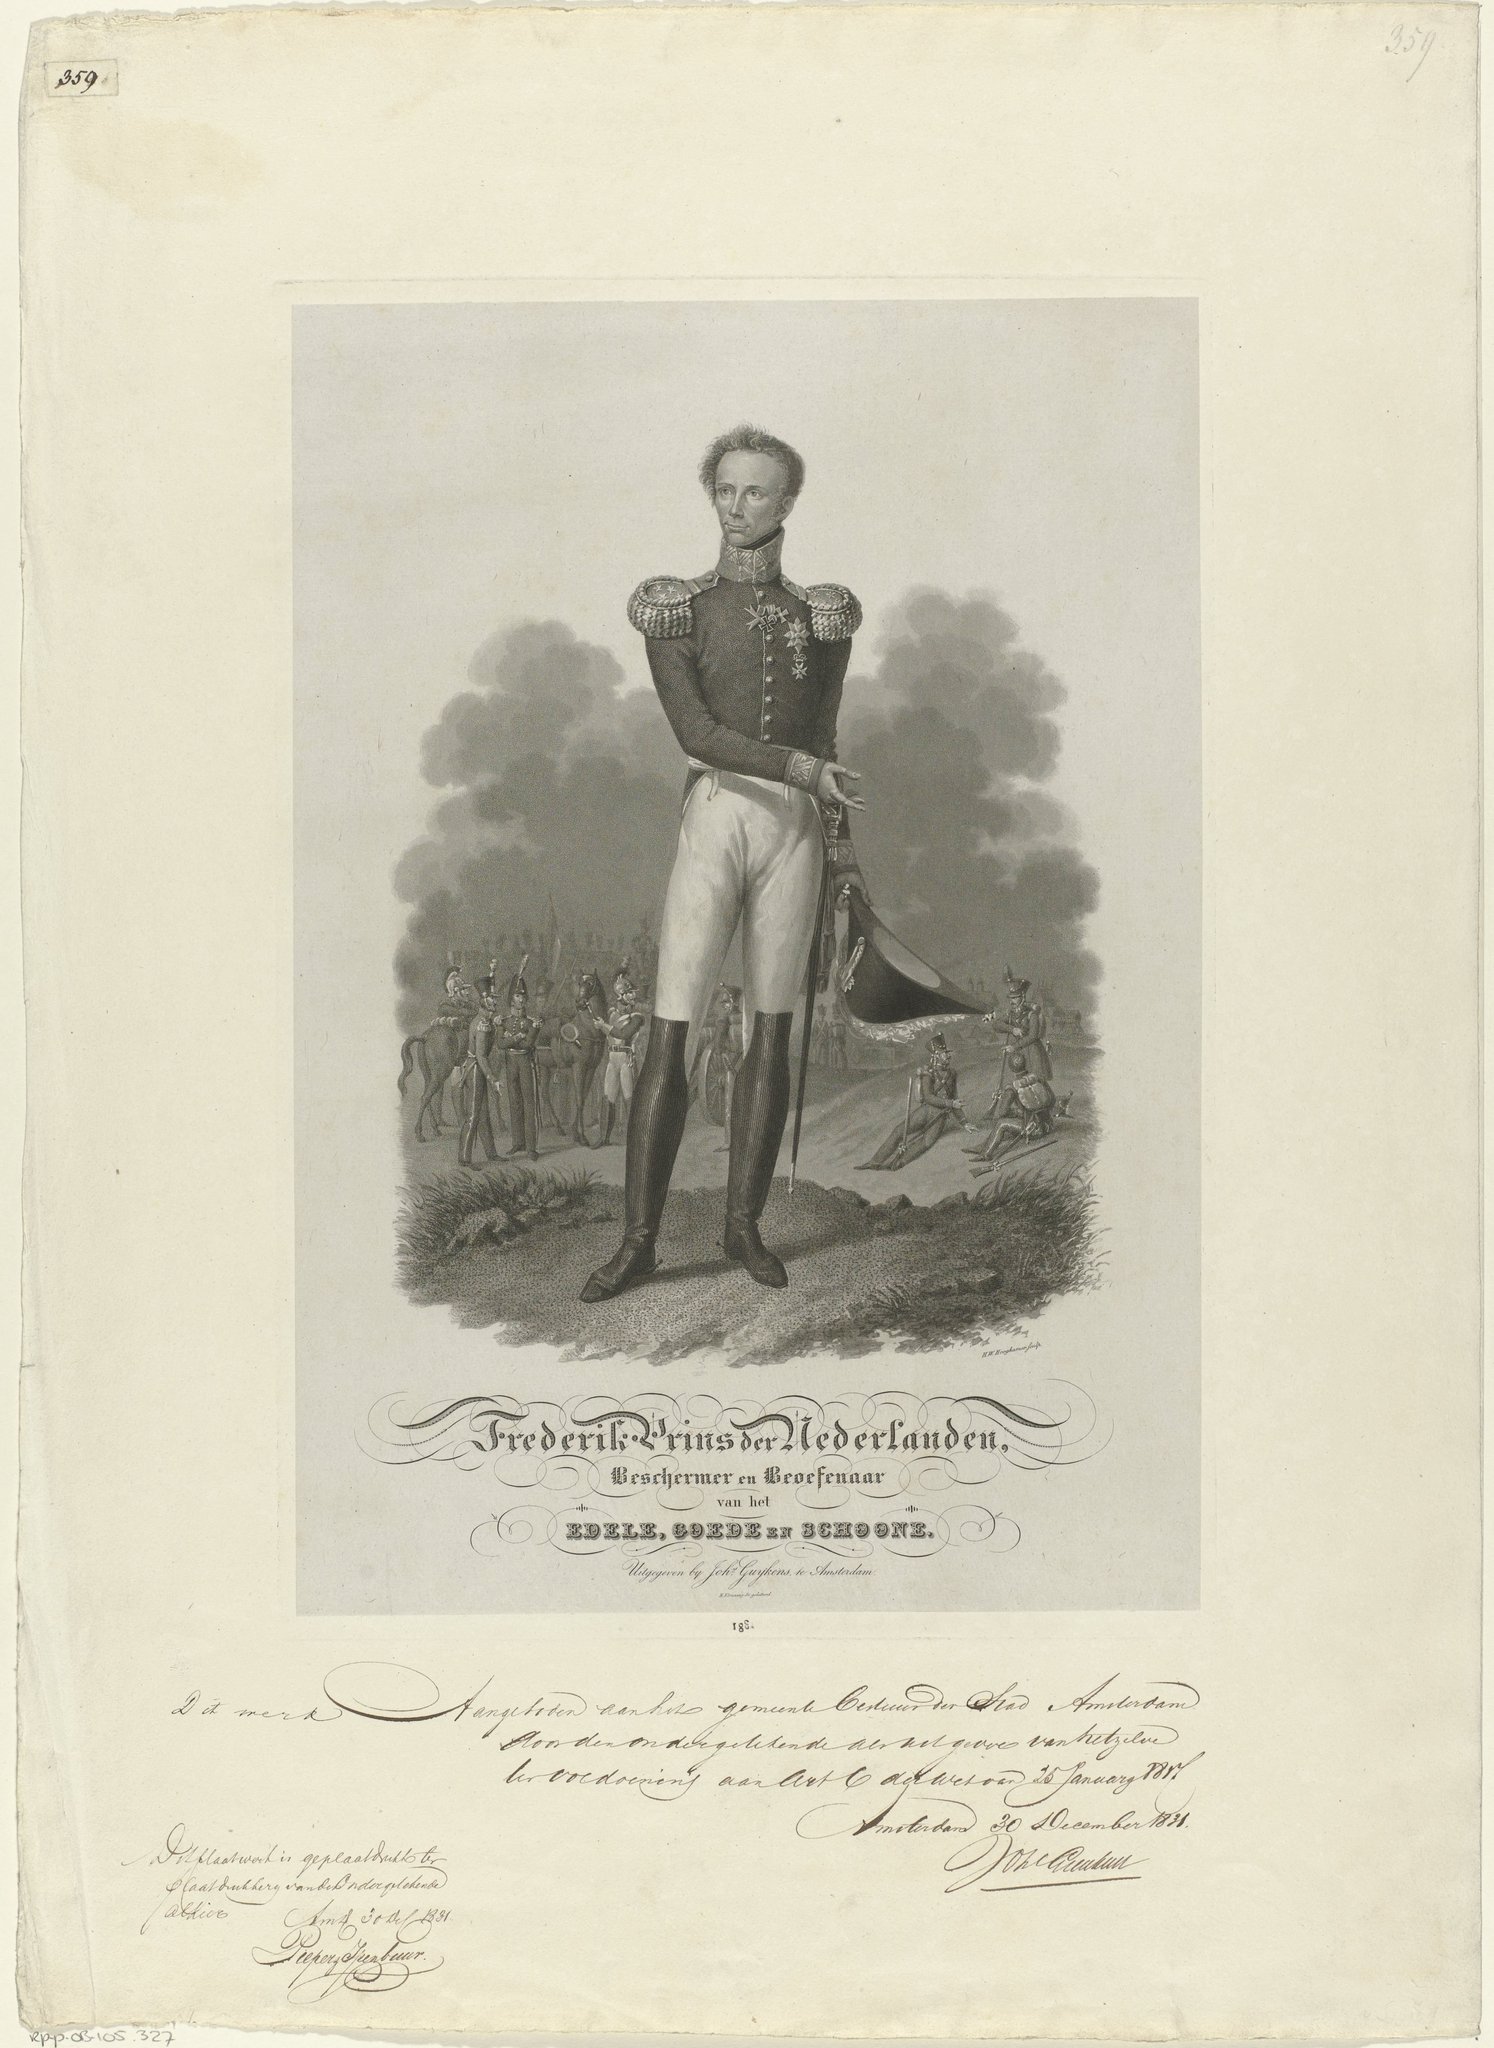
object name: print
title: Portret van Frederik, prins der Nederlanden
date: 1815-1864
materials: paper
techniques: aquatint, engraving, etching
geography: amsterdam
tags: berlin, frederik (prins der nederlanden)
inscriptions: : ‘Dit werk Aangeboden aan het gemeente Bestuur der Stad Amsterdam door den ondergetekende als uitegevr van hetzelve ter voldoening aan art. 6 der wet van 25 Januarij 1817 / Amsterdam 30 December 1831 Joh Guikens’, : ‘Dit plaatwerk is geplaatdrukt ter plaatdrukkerij van den ondergetekende alhier / Amst. 30 Dec 1831 / Pieper & Ipenbuur.’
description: De hier vermelde titel verwijst naar de hoogst verkregen titel van de geportretteerde, niet per se naar de titel die de geportretteerde op deze voorstelling draagt.